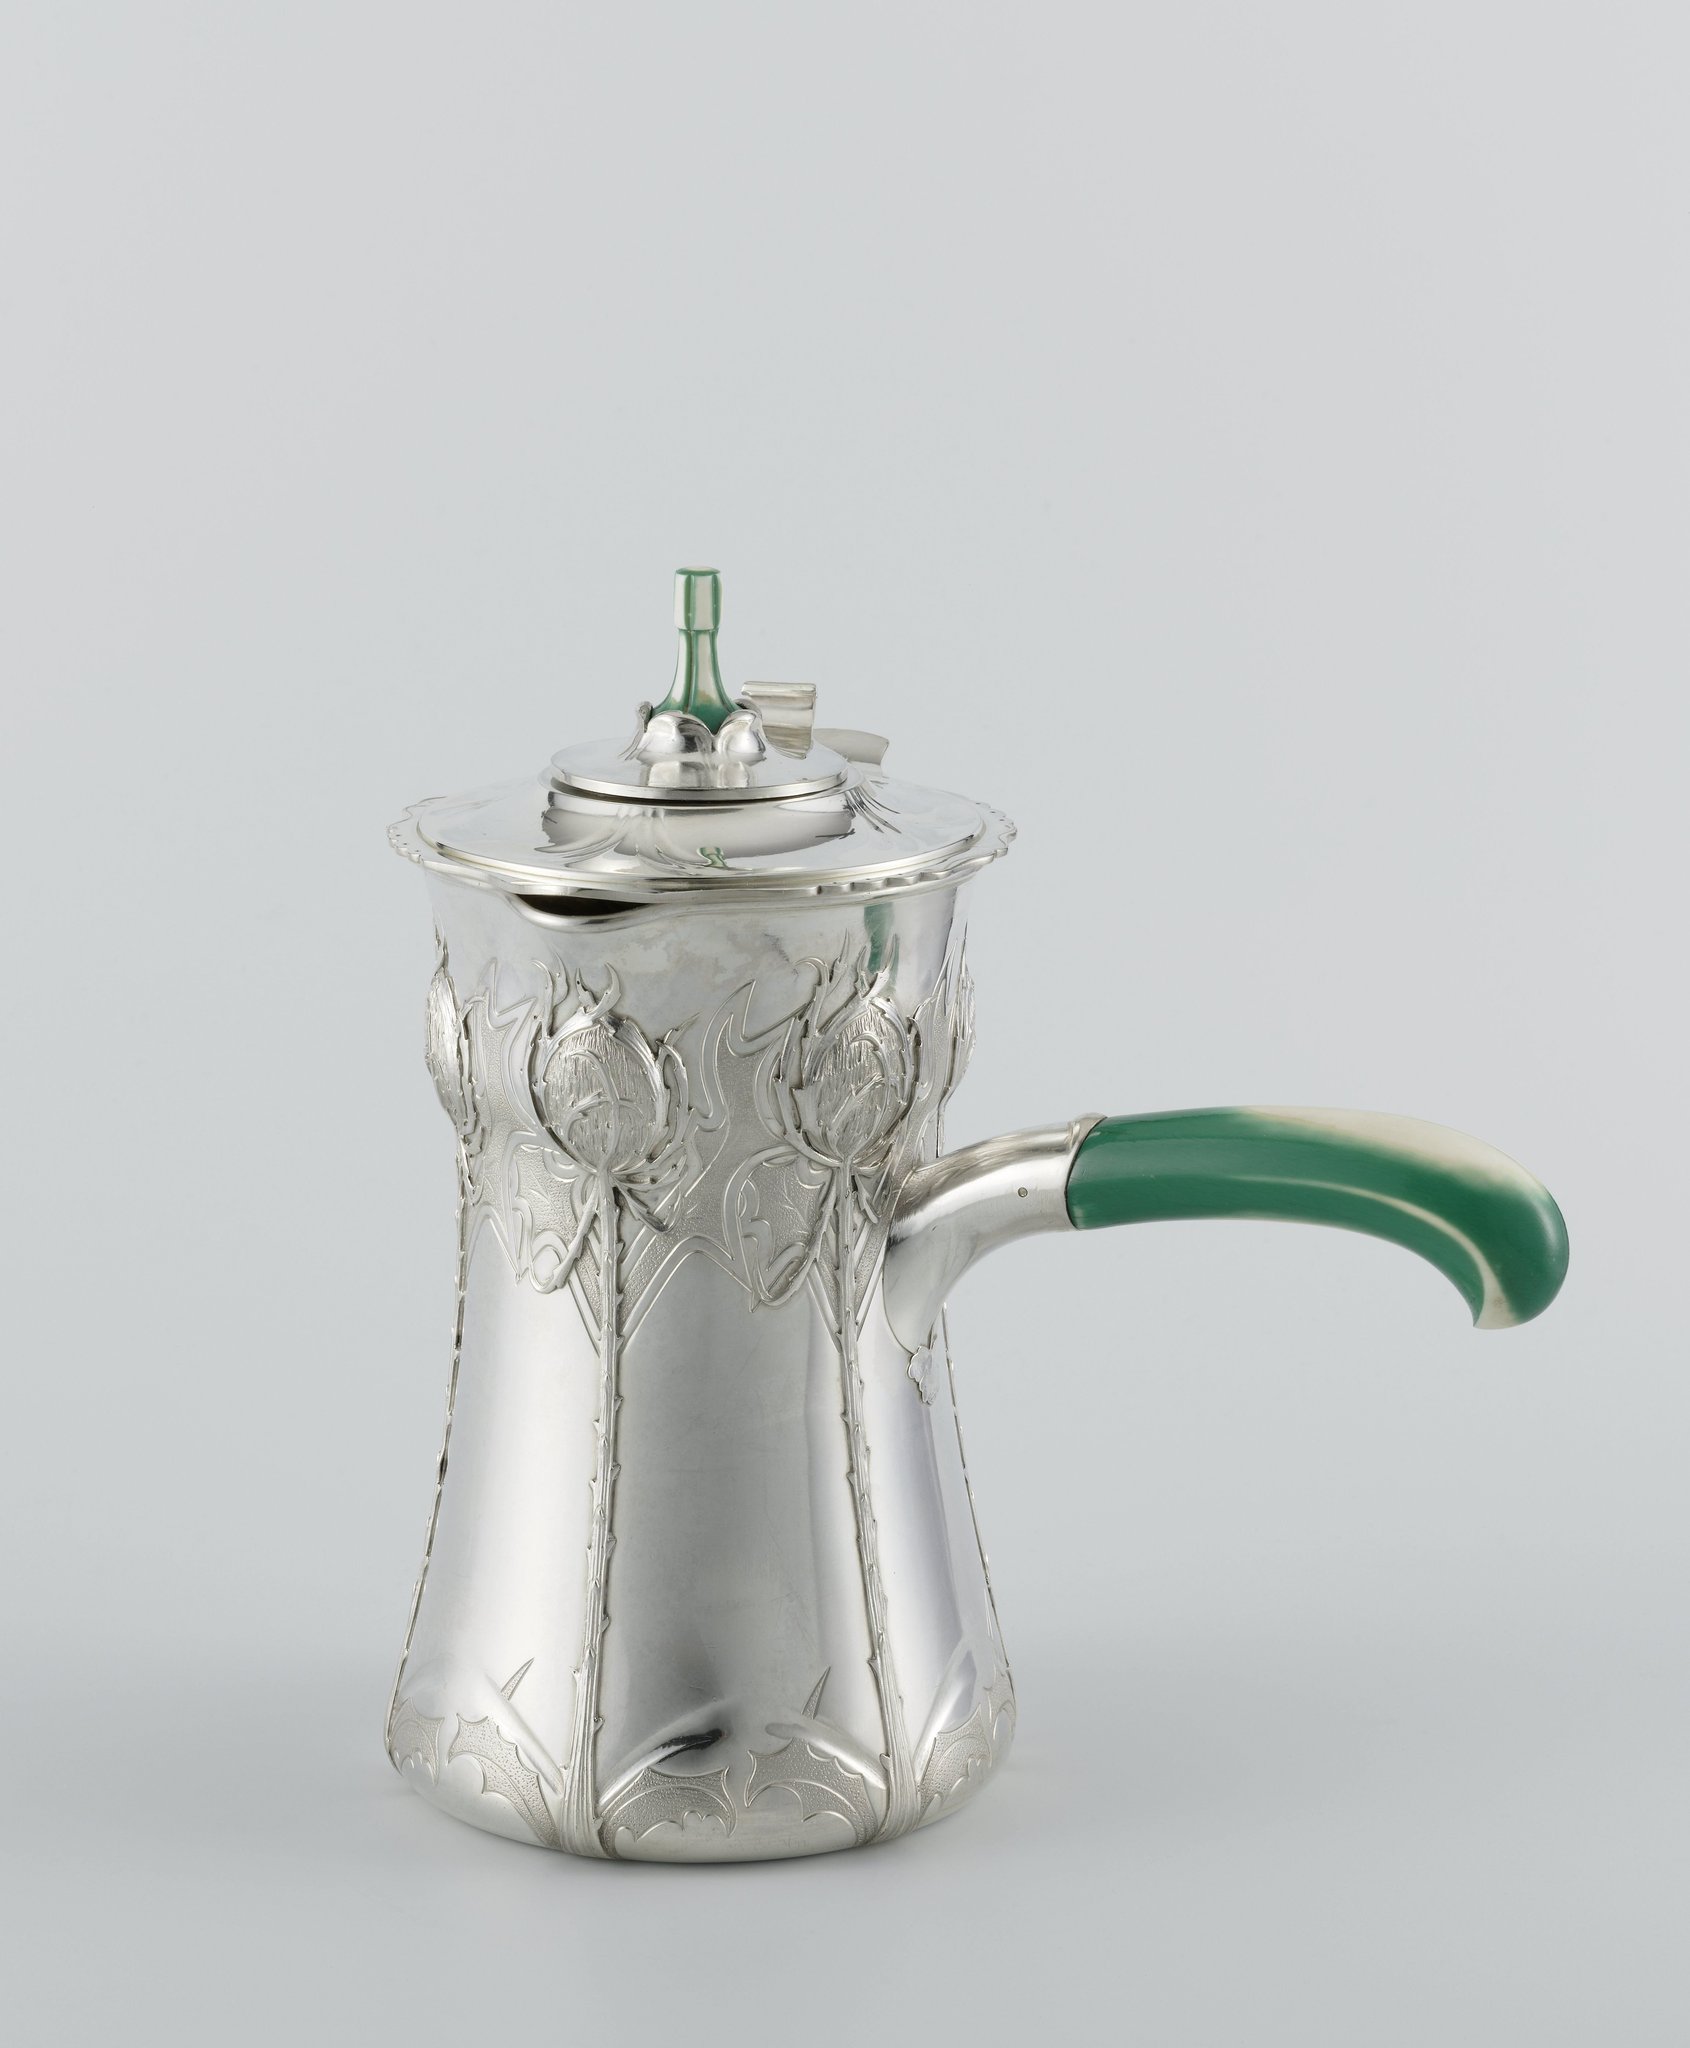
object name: chocolate pot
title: Chocolate pot with a molinet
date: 1900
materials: ivory, silver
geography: paris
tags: flowers ~ ornament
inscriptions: alloy mark, maker's mark, mark: ‘CARDEILHAC/ PARIS’, mark: ‘K SC2’, import mark, import mark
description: The firm of Ernest Cardeilhac produced an accessible form of Art Nouveau silver. The designs are characterized by a combination of motifs based on nature in a repetitive pattern, in this case stylized thistles. The molinet (stirring rod) was used to stir and make the cocoa frothy.